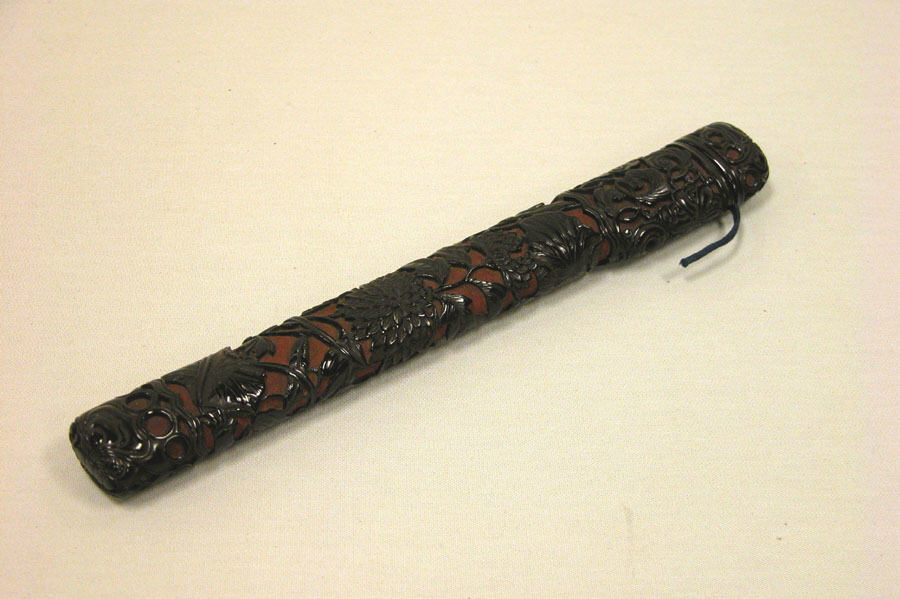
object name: pipe case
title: Pipe Case with Design of Flowers and Butterflies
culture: japanese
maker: tamakaji zōkoku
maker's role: artist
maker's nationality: japanese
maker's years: 1803-1866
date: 1801-1900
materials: lacquer, silver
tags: butterflies,flowers